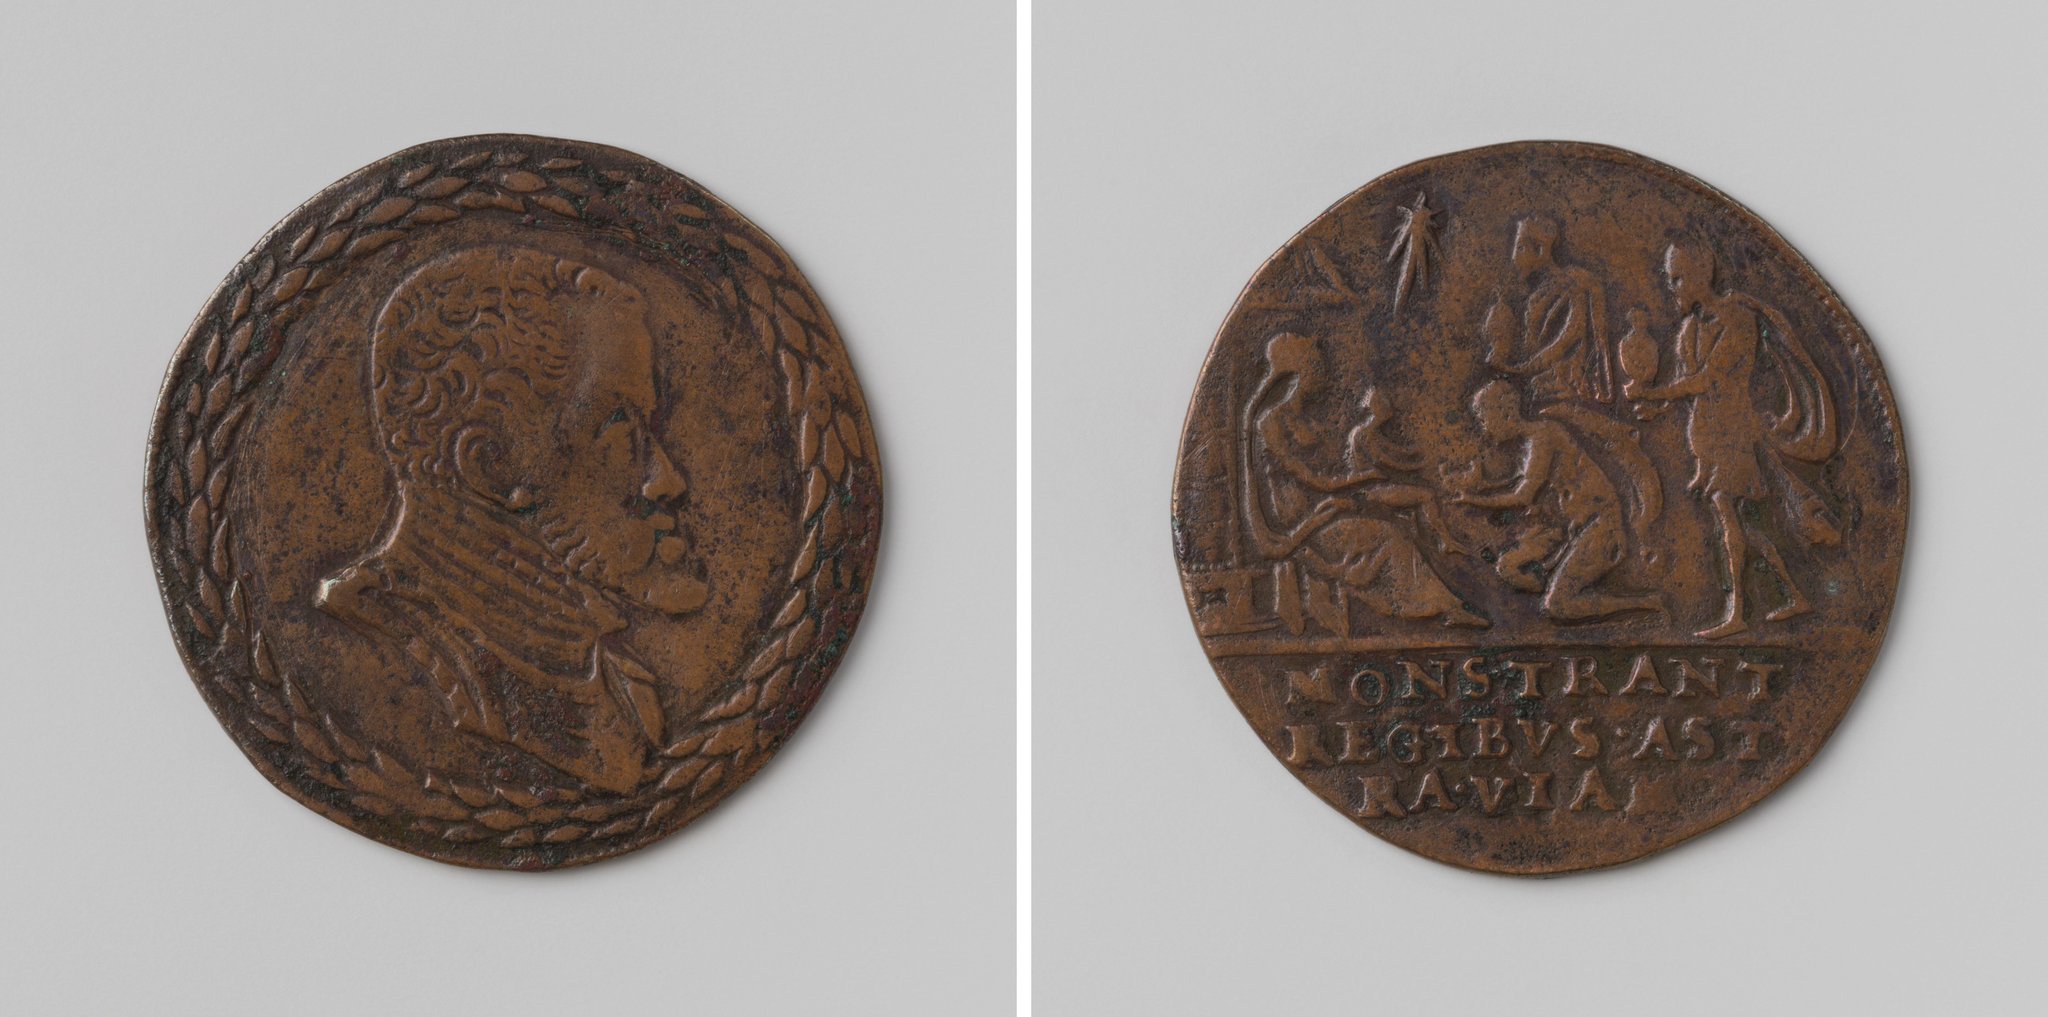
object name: jeton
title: Filips II, koning van Spanje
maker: Anonymous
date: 1558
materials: copper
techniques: striking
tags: philip ii of spain